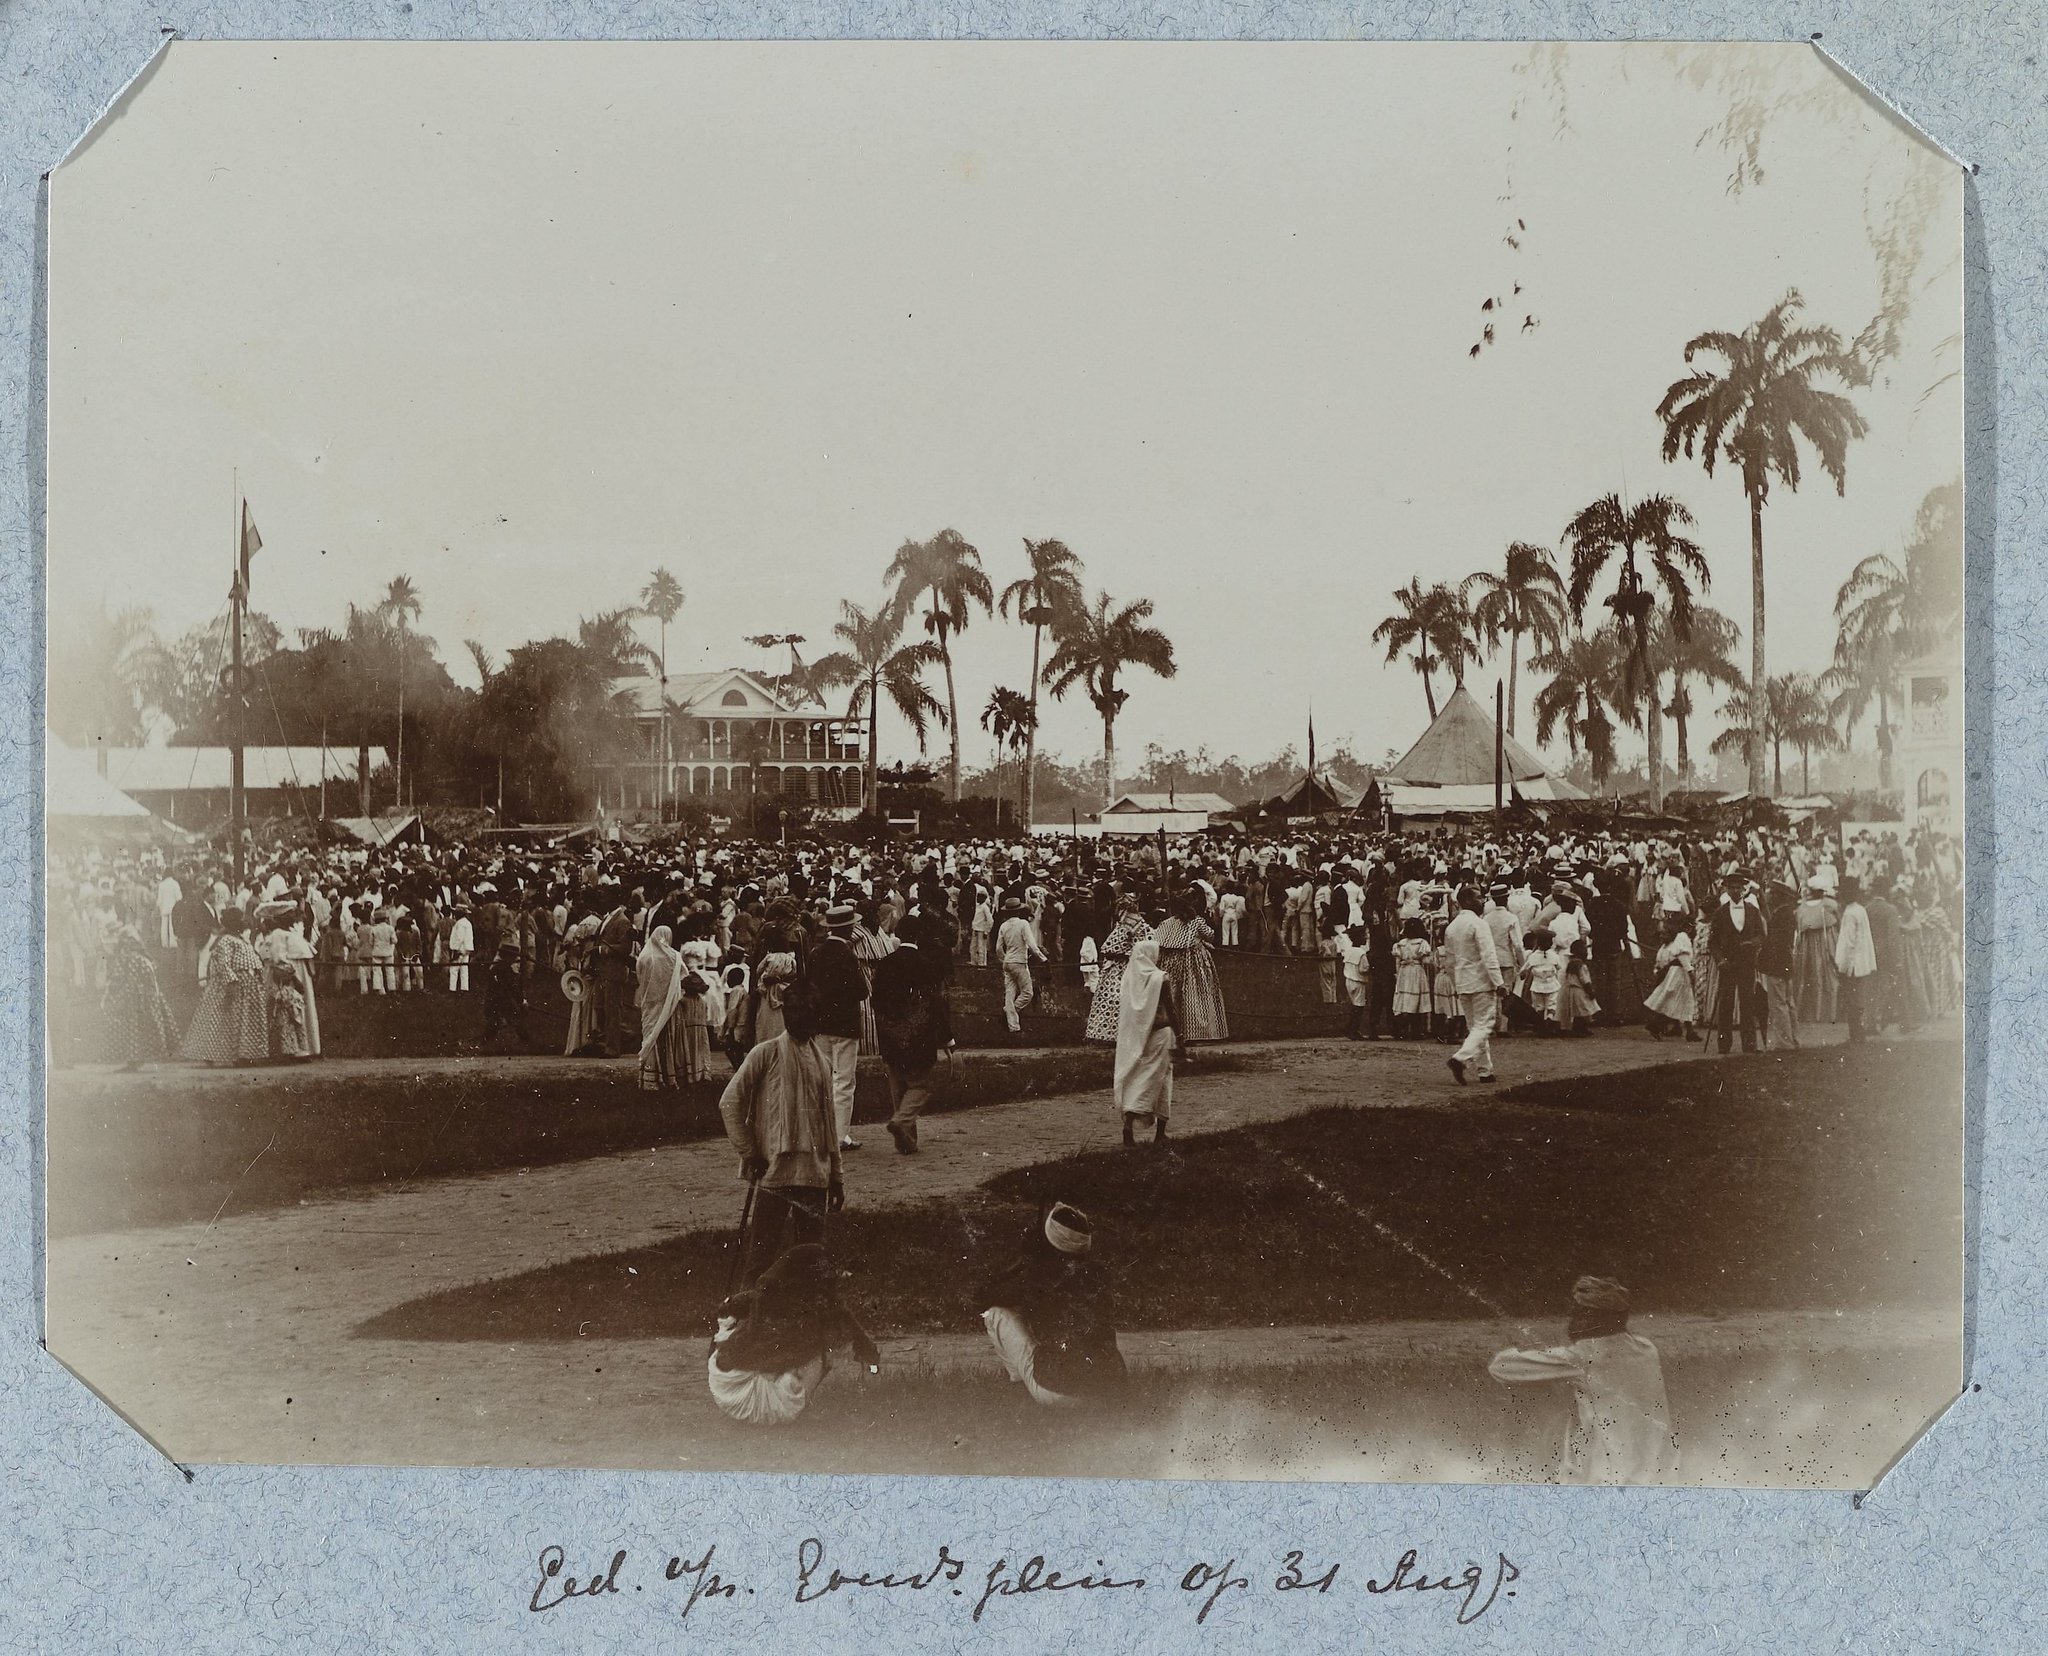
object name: photograph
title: Ged. v/h Gouvs.plein op 31 Augs.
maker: théodore van lelyveld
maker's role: painter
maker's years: 1867-1954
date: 1895-1898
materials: photographic support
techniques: collodion silver print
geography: suriname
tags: public festivities on the occasion of royal events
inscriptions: inscription: ‘Ged. v/h Gouvs.plein op 31 Augs.’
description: Feestelijkheden op het Gouvernementsplein te Paramaribo op Koninginnedag 31 augustus. Grote groep Surinaamse mannen met vrouwen in kotomisi. Fotoafdruk in een fotoalbum van Théodore van Lelyveld over Suriname uit 1895-1898.